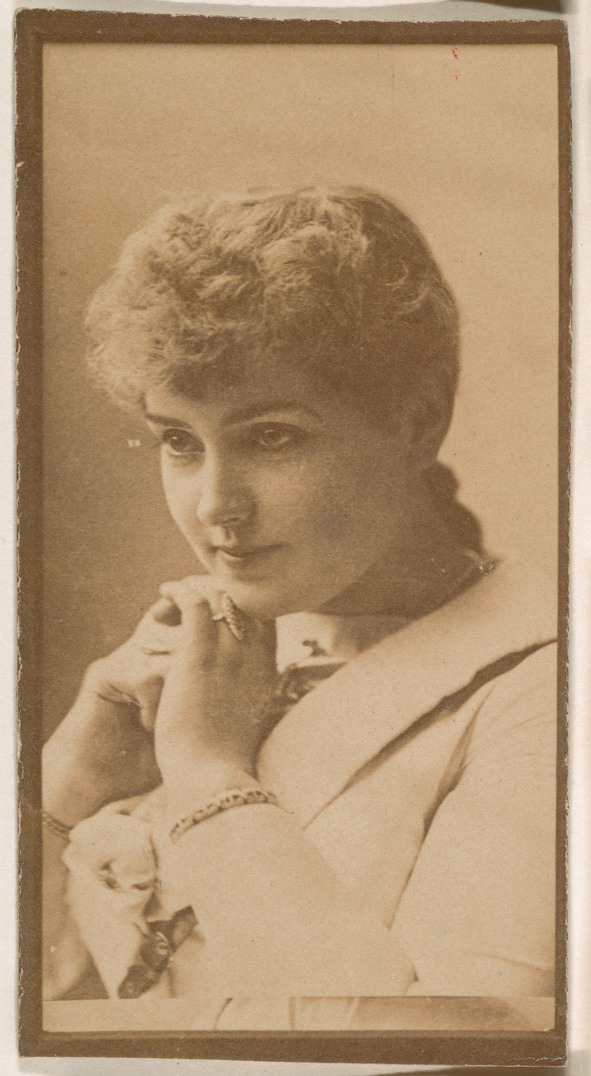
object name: photograph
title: Actress resting chin on hands from the Actresses series (N664) promoting Old Fashion Fine Cut Tobacco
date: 1888-1890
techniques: albumen silver print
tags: portraits,women,actresses